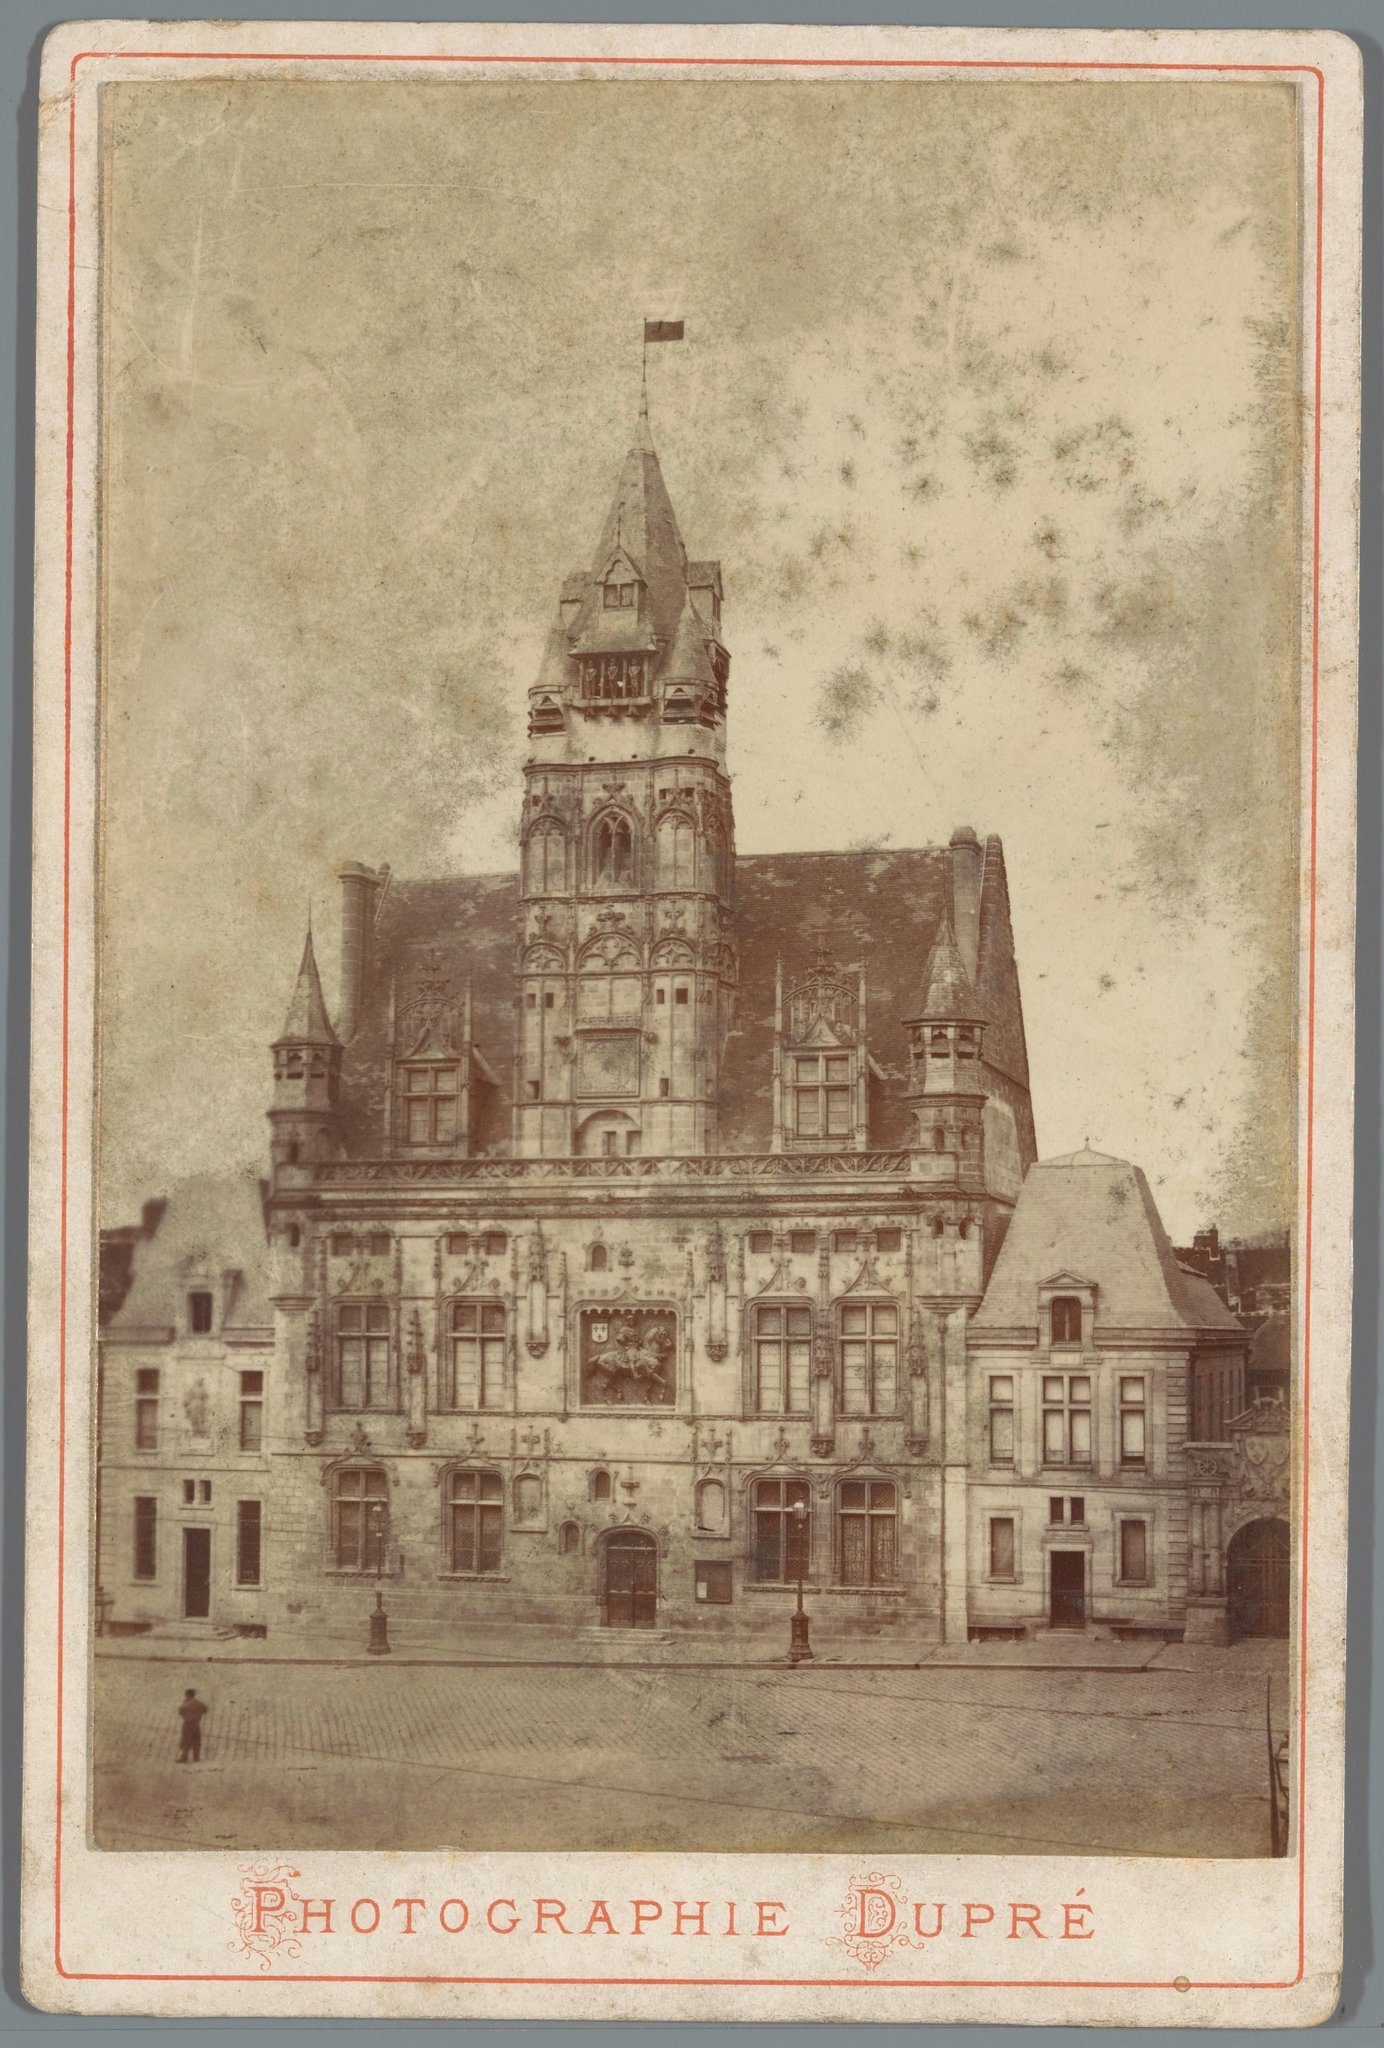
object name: cabinet photograph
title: Stadhuis in Compiègne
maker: a. dupré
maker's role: fotograaf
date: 1870-1890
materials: paper, cardboard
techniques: gelatin silver print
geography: compiègne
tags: townhall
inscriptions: inscription: ‘A. Dupré/ photographe/ AD/ Rue Solférino, 39,/ Compiègne’